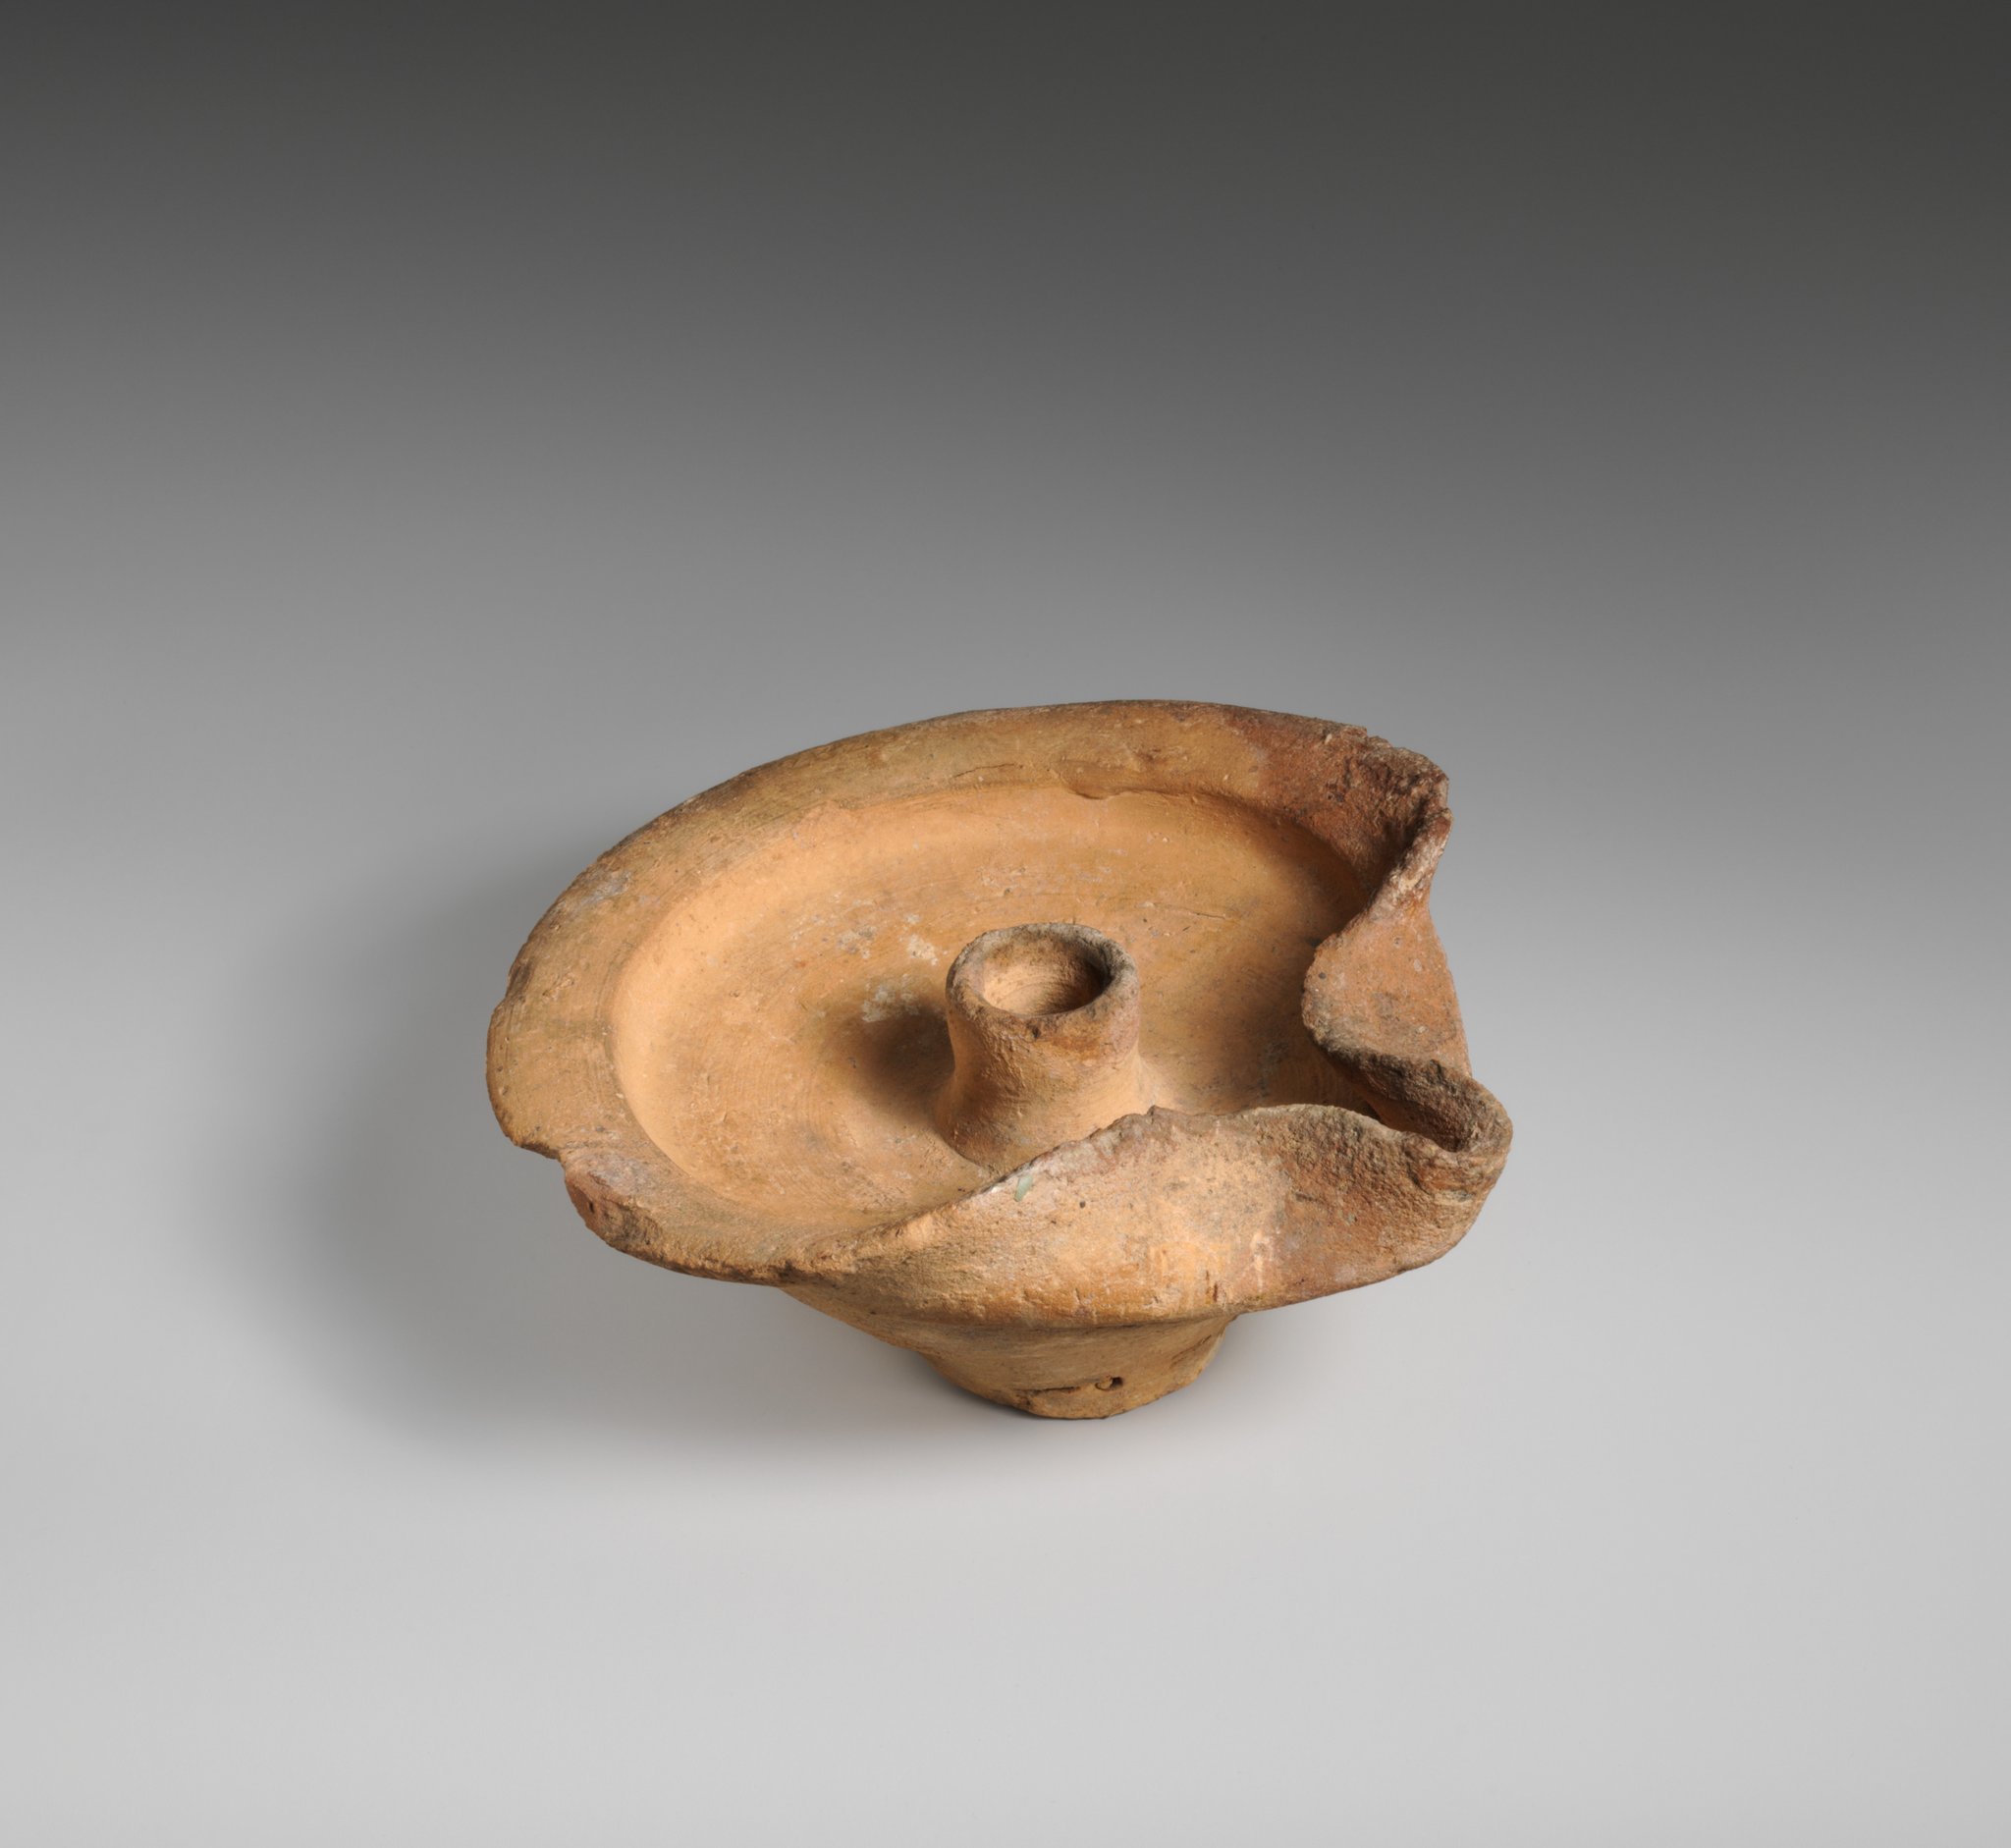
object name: lamp, saucer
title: Terracotta saucer-shaped lamp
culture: cypriot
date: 400-201 BCE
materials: terracotta